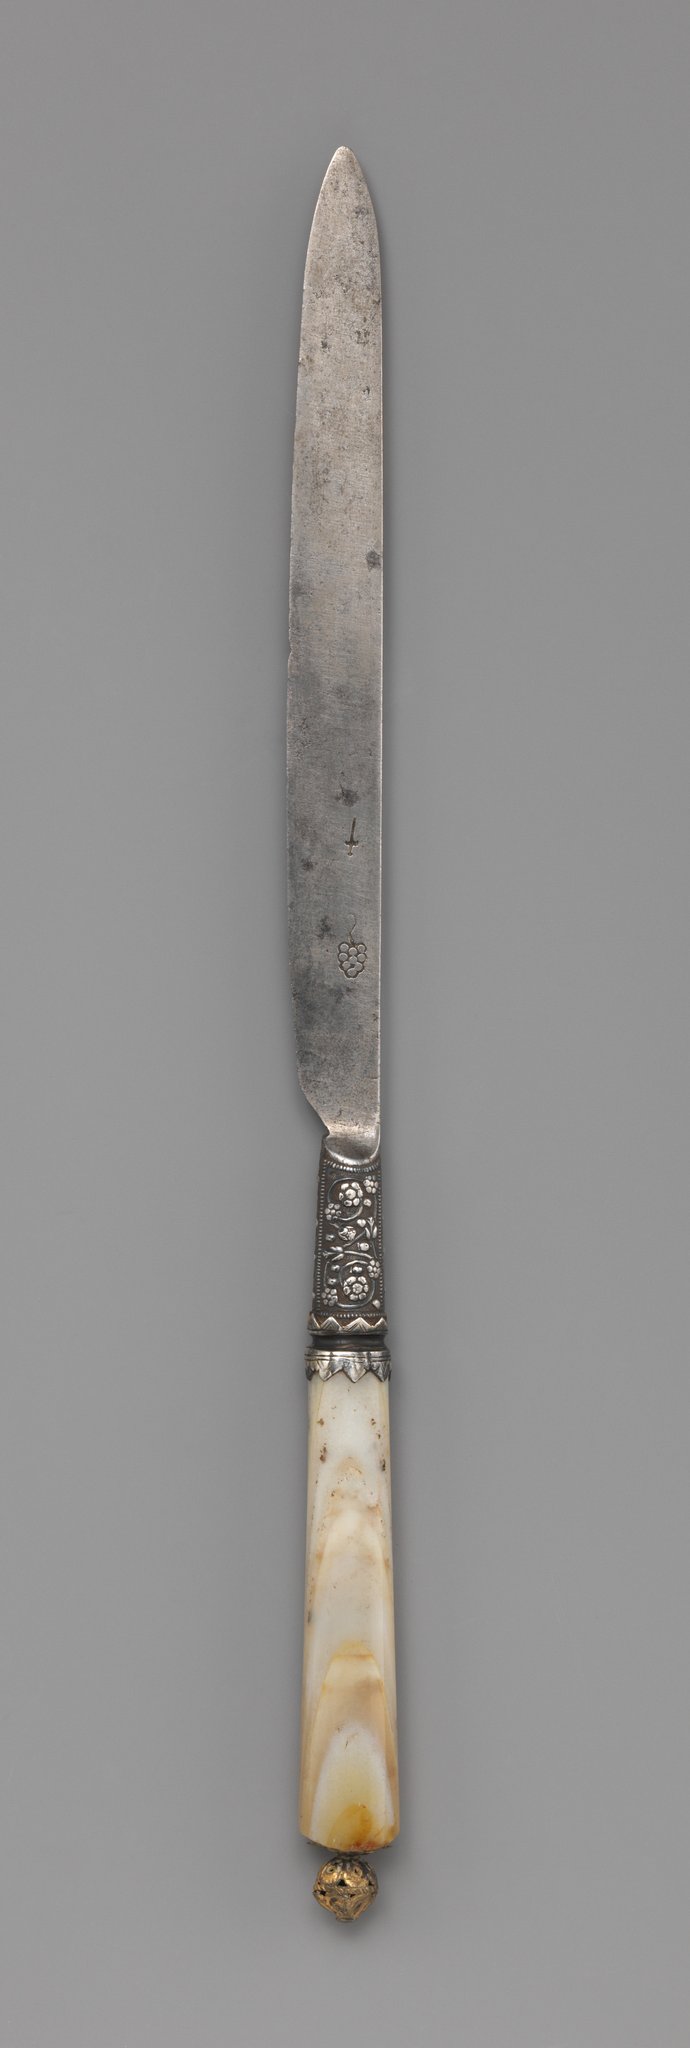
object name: table knife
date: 1601-1625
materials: stone, silver, steel